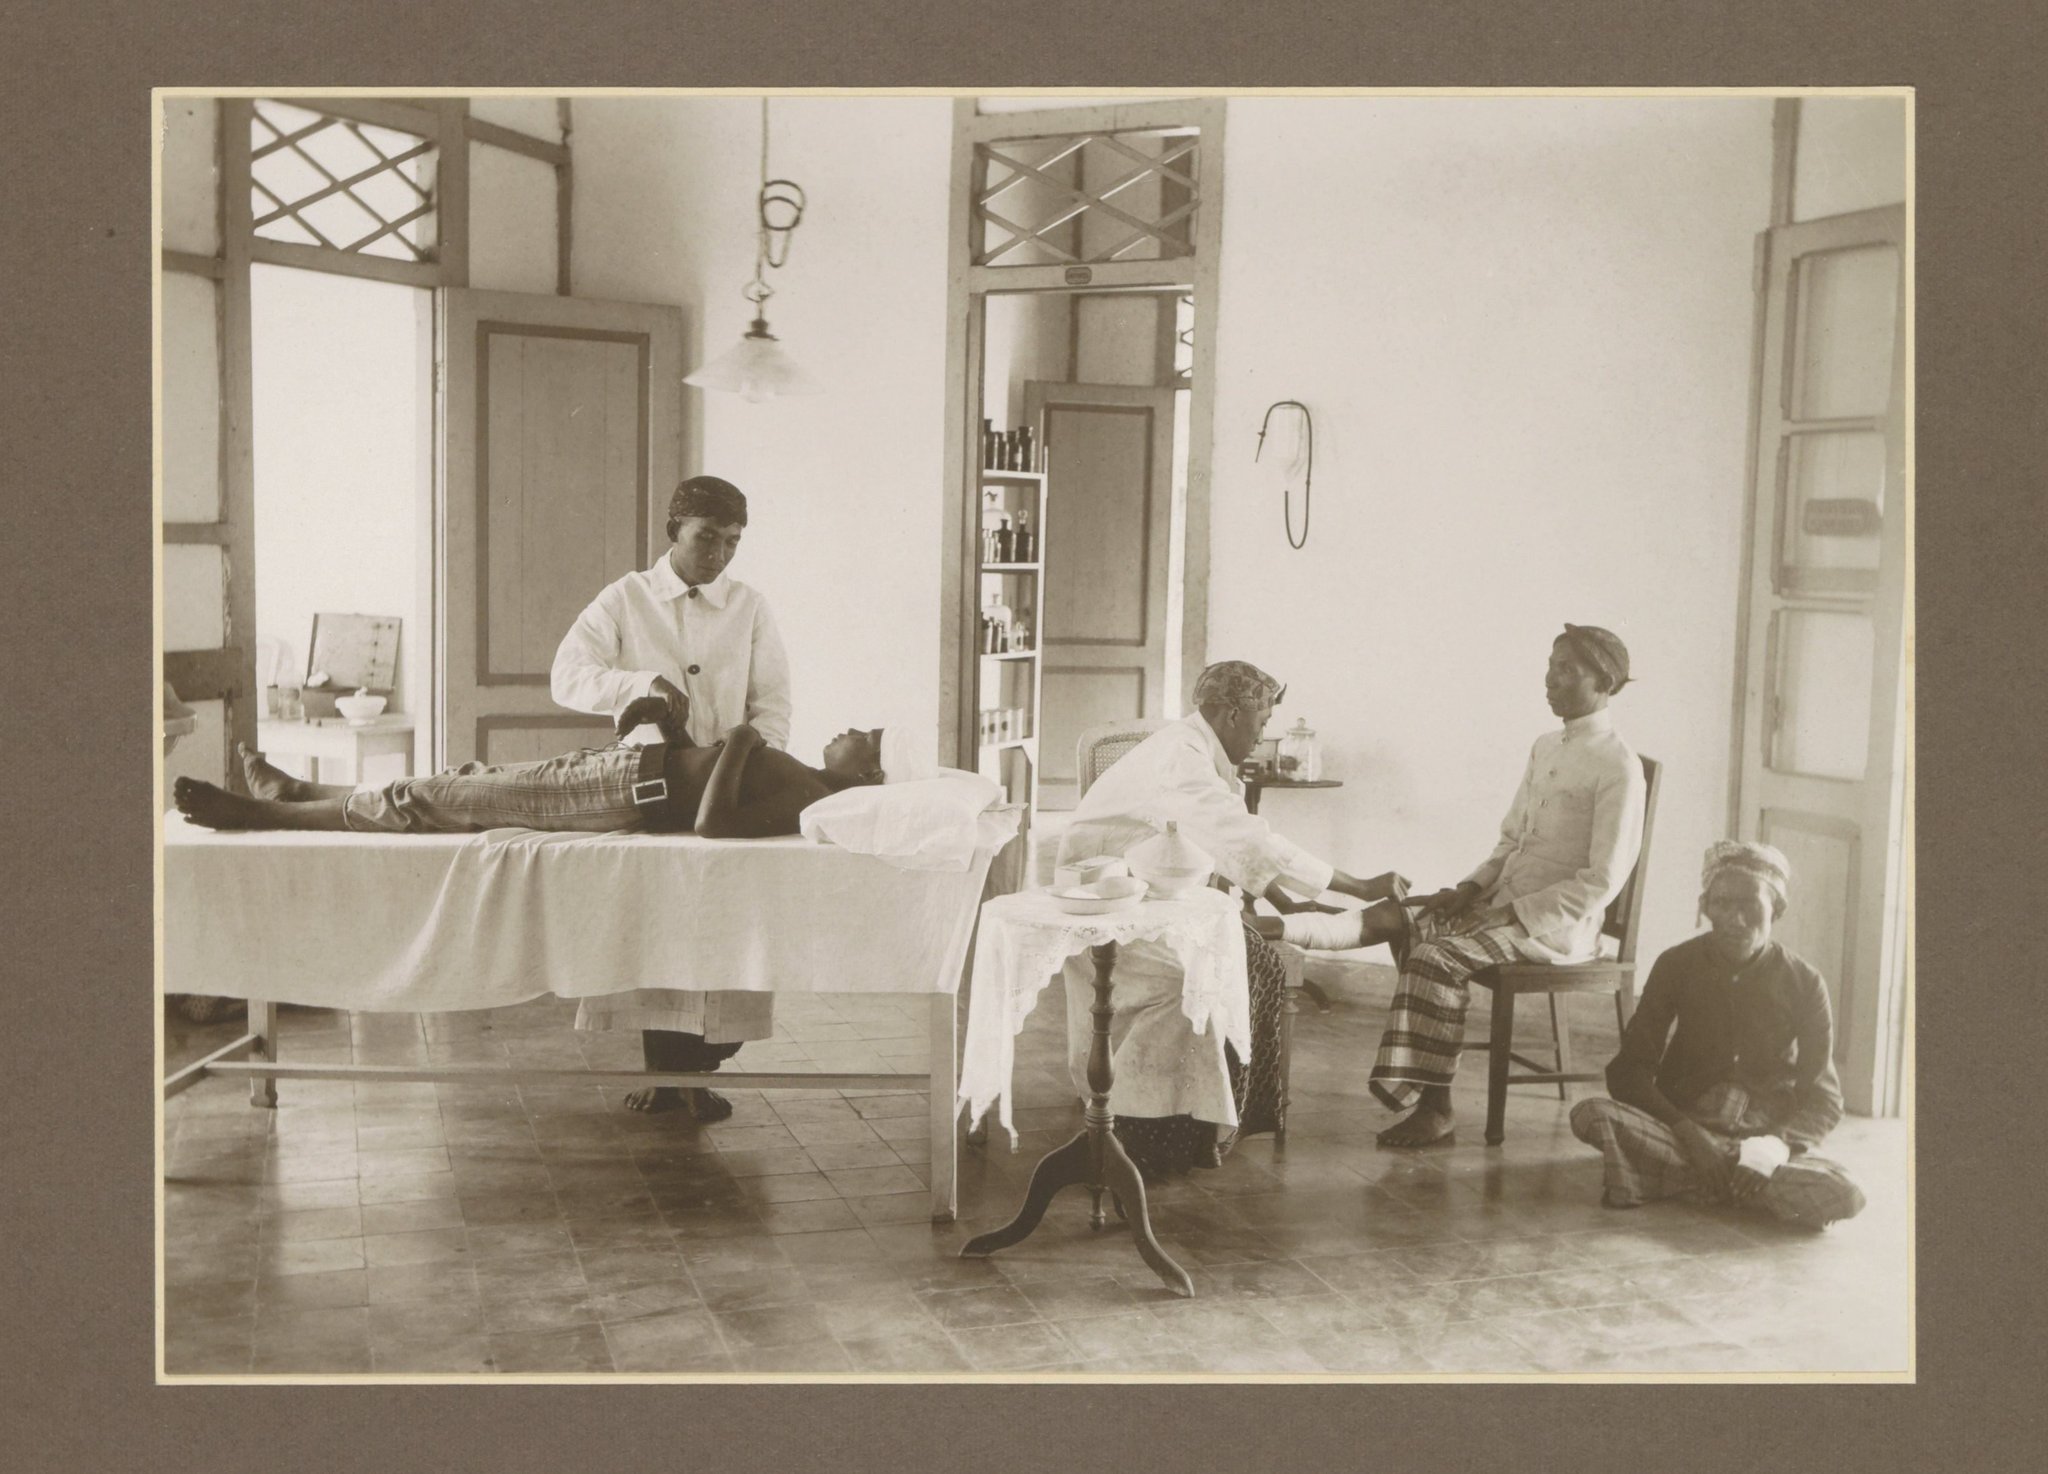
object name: photograph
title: Verplegers en patiënten in de polikliniek van suikerfabriek Goedo te Djombang op Java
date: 1925-1930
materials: cardboard, paper, photographic support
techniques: gelatin silver print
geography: jombang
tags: plantation, physician, doctor, hospital, patient, sick person, plants and herbs: sugarcane, sugar, dutch east indies, the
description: Onderdeel van Fotoalbum met opnames van vier suikerfabrieken op Java.